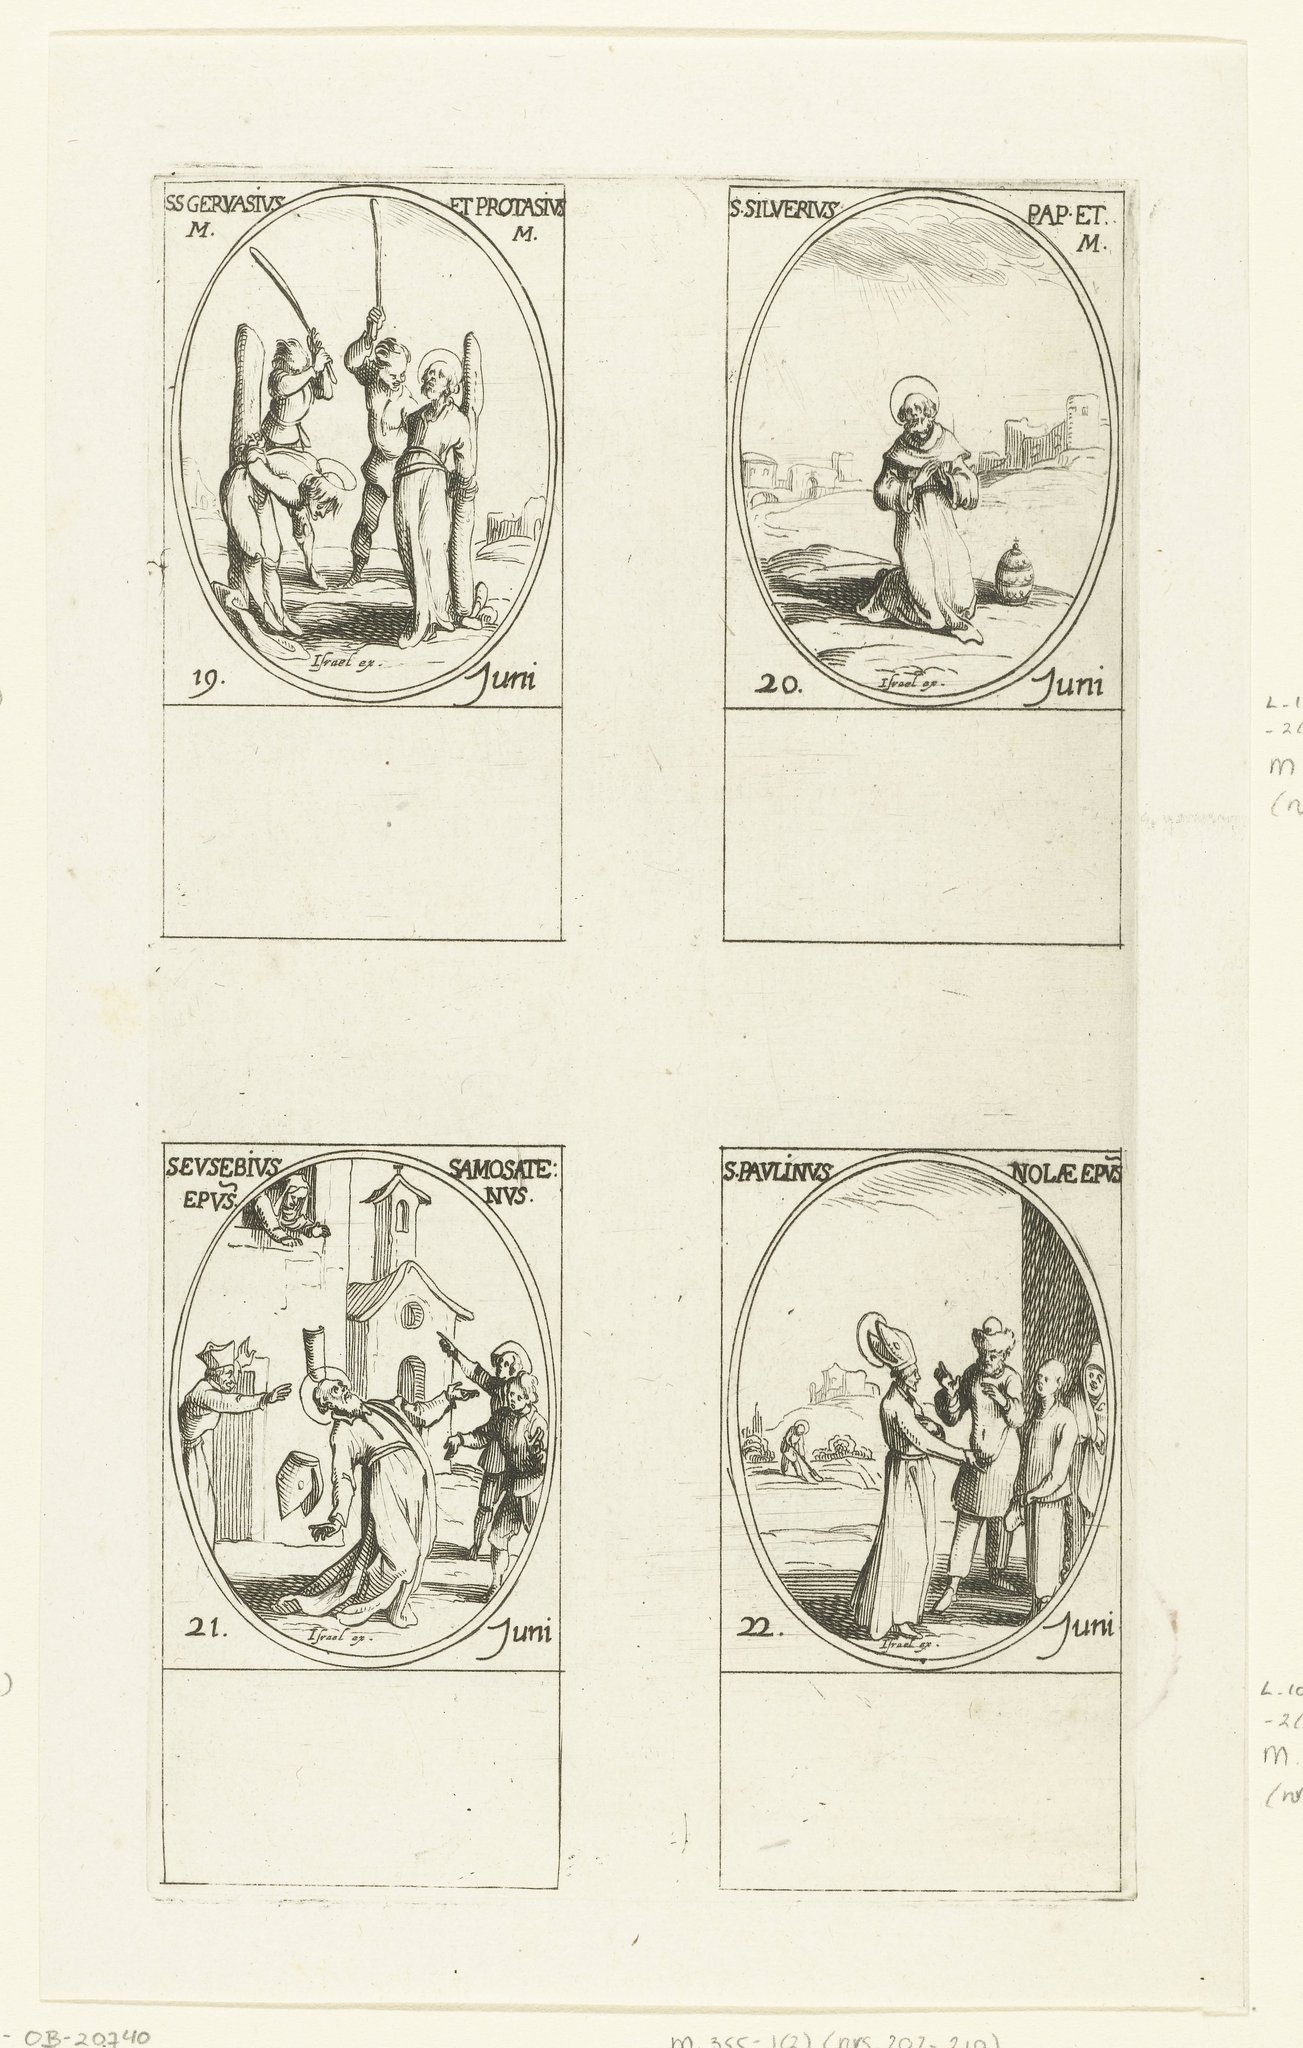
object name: print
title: Alle heiligen en de Christelijke feestdagen van het jaar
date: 1632-1636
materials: paper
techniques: etching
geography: nancy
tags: male saints (with name), martyrdom, suffering, misfortune, death of st. gervase & protase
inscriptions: collector's mark: Lugt 240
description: Blad met vier ovale voorstellingen, elk met opschrift en datum in het Latijn: linksboven de Heilige Gervasius en de Heilige Protasius die dood worden geslagen, rechtsboven de Heilig Silverius geknield naast een tiara, linksonder de Heilige Eusebius van Samosata die een dakpan op zijn hoofd krijgt, rechtsonder de Heilige Paulinus van Nola in gesprek met drie mensen. Deze prent is onderdeel van een serie prenten met voorstellingen van de heiligen en de christelijke feestdagen van het jaar. Er zijn steeds vier scènes van één plaat op één blad gedrukt. Inclusief bijbehorend titelblad en frontispice gaat het in totaal om 124 platen (490 voorstellingen). De drie platen met de laatste 12 scènes (de veranderlijke christelijke feestdagen) zijn in de derde staat versneden tot 12 kleine plaatjes, en met een apart titelblad uitgegeven.